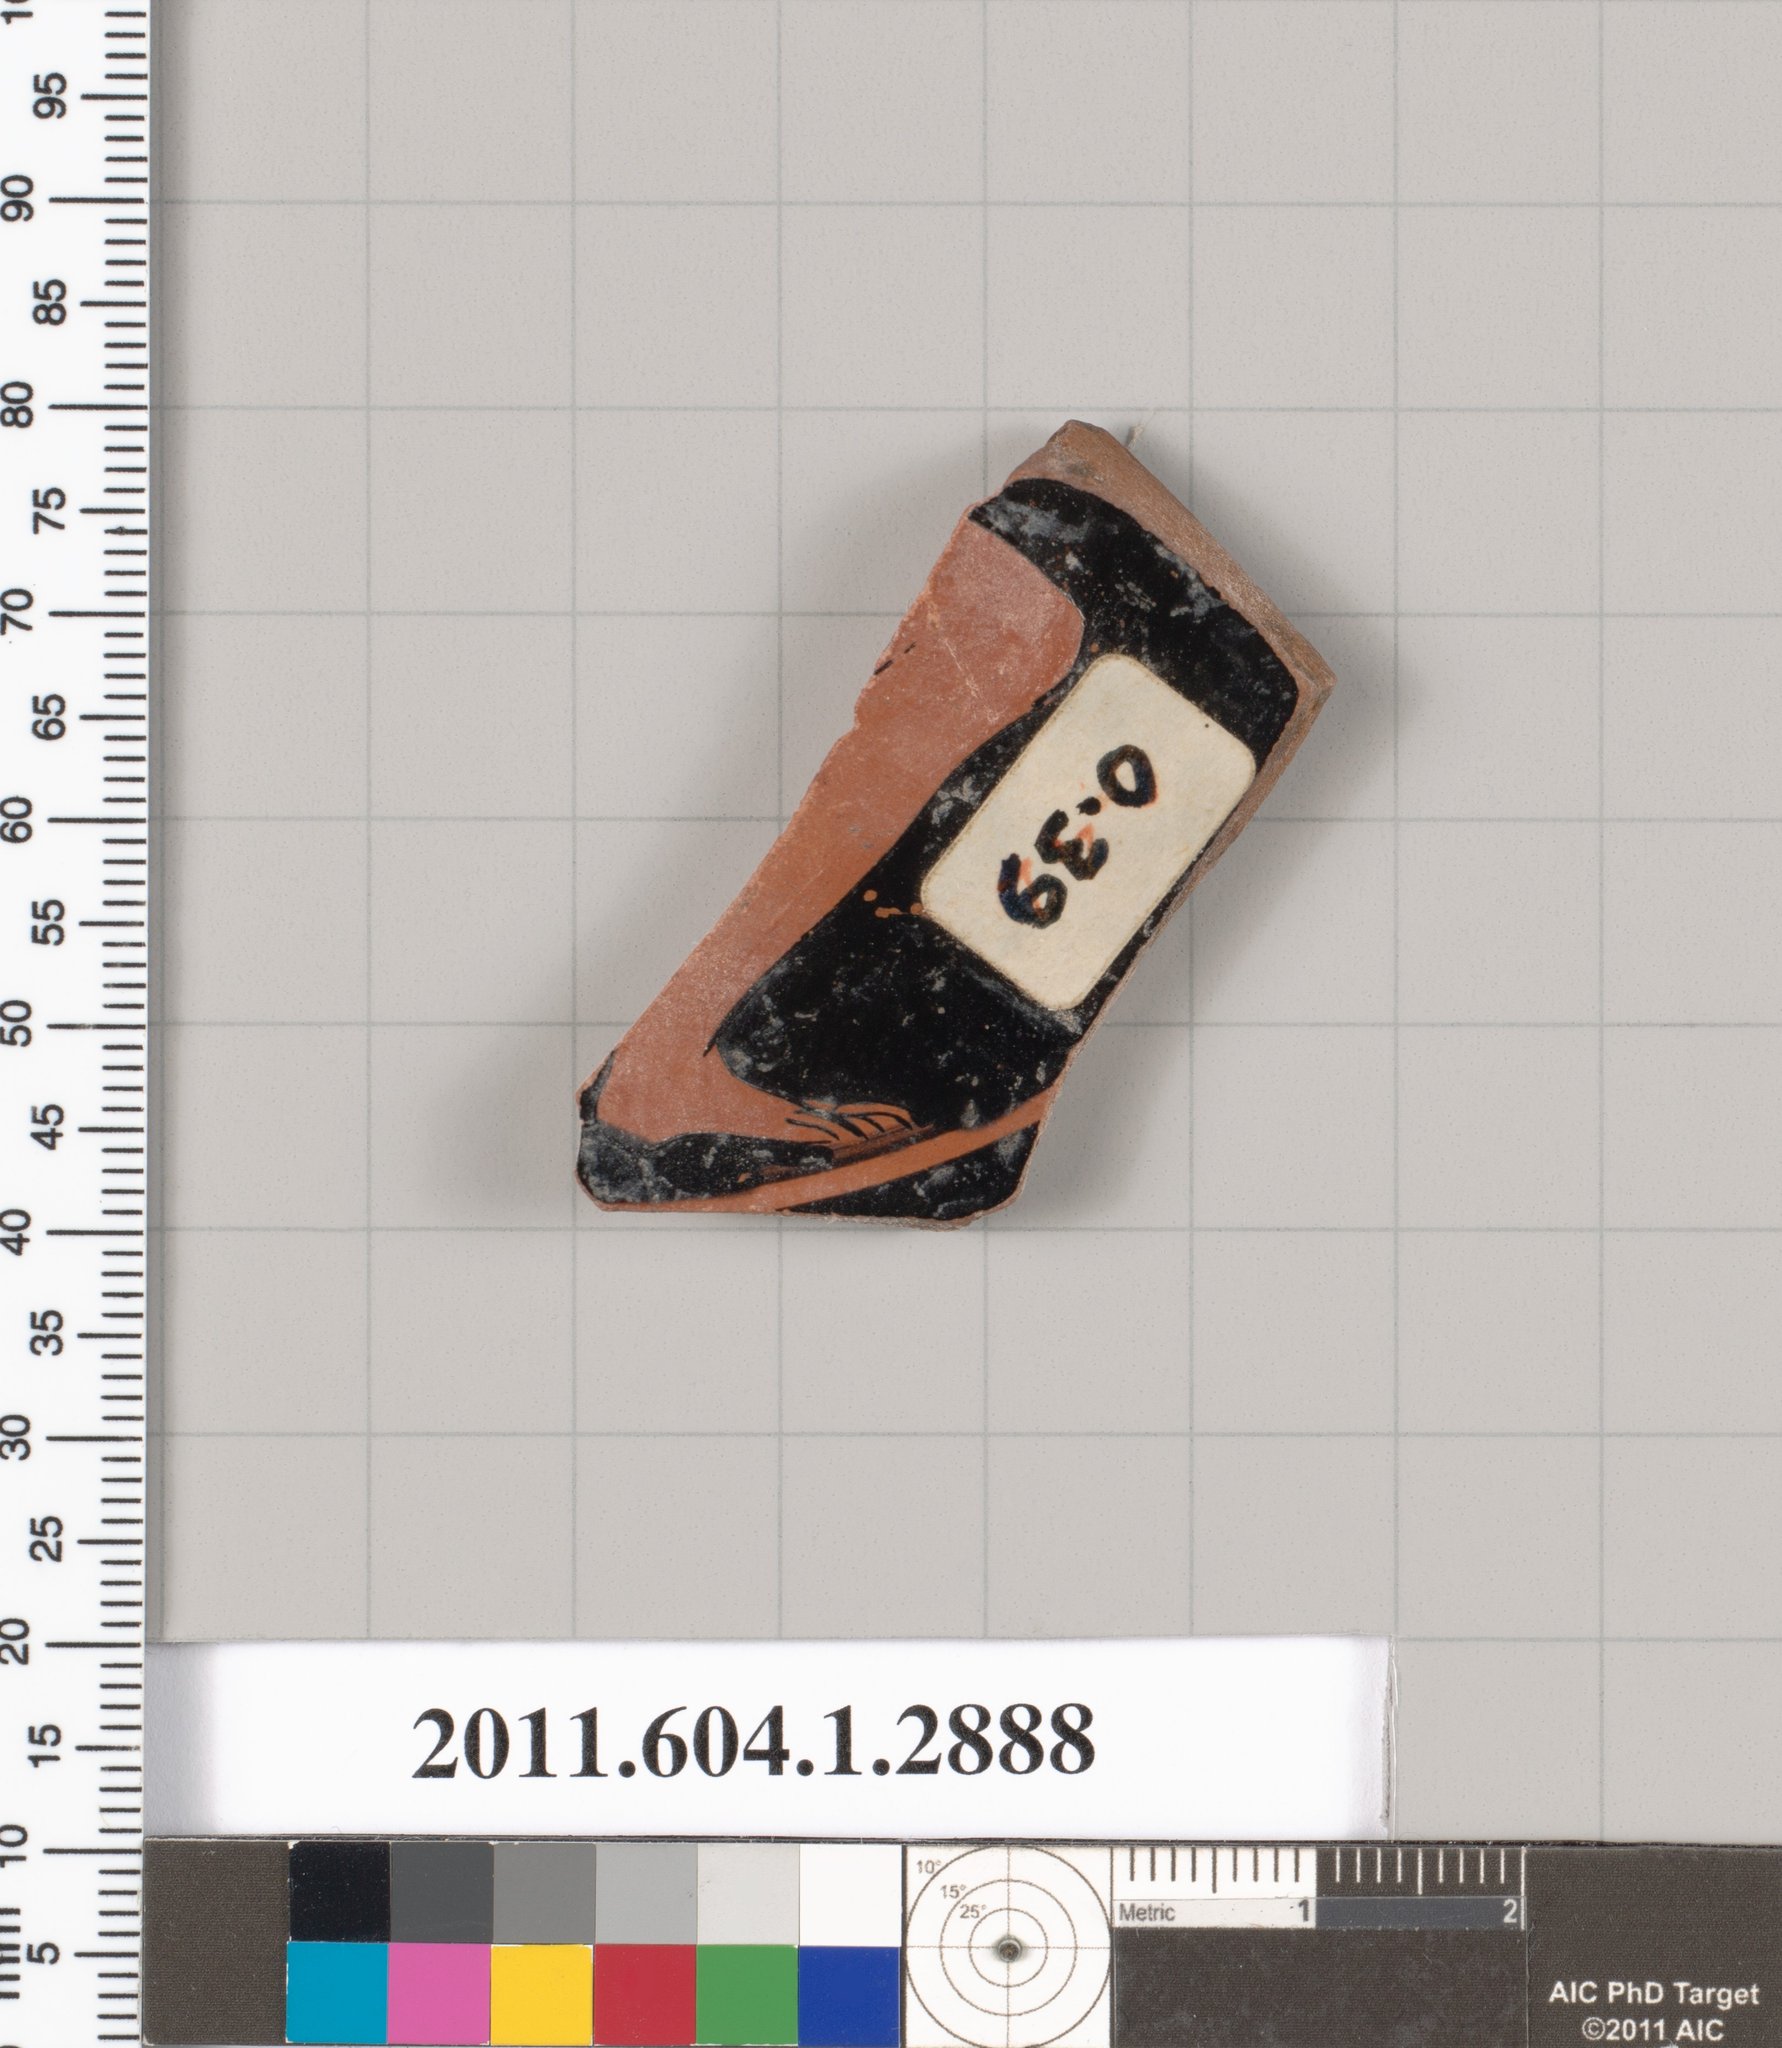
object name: kylix fragment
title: Terracotta fragment of a kylix (drinking cup)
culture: greek, attic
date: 520-500 BCE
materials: terracotta